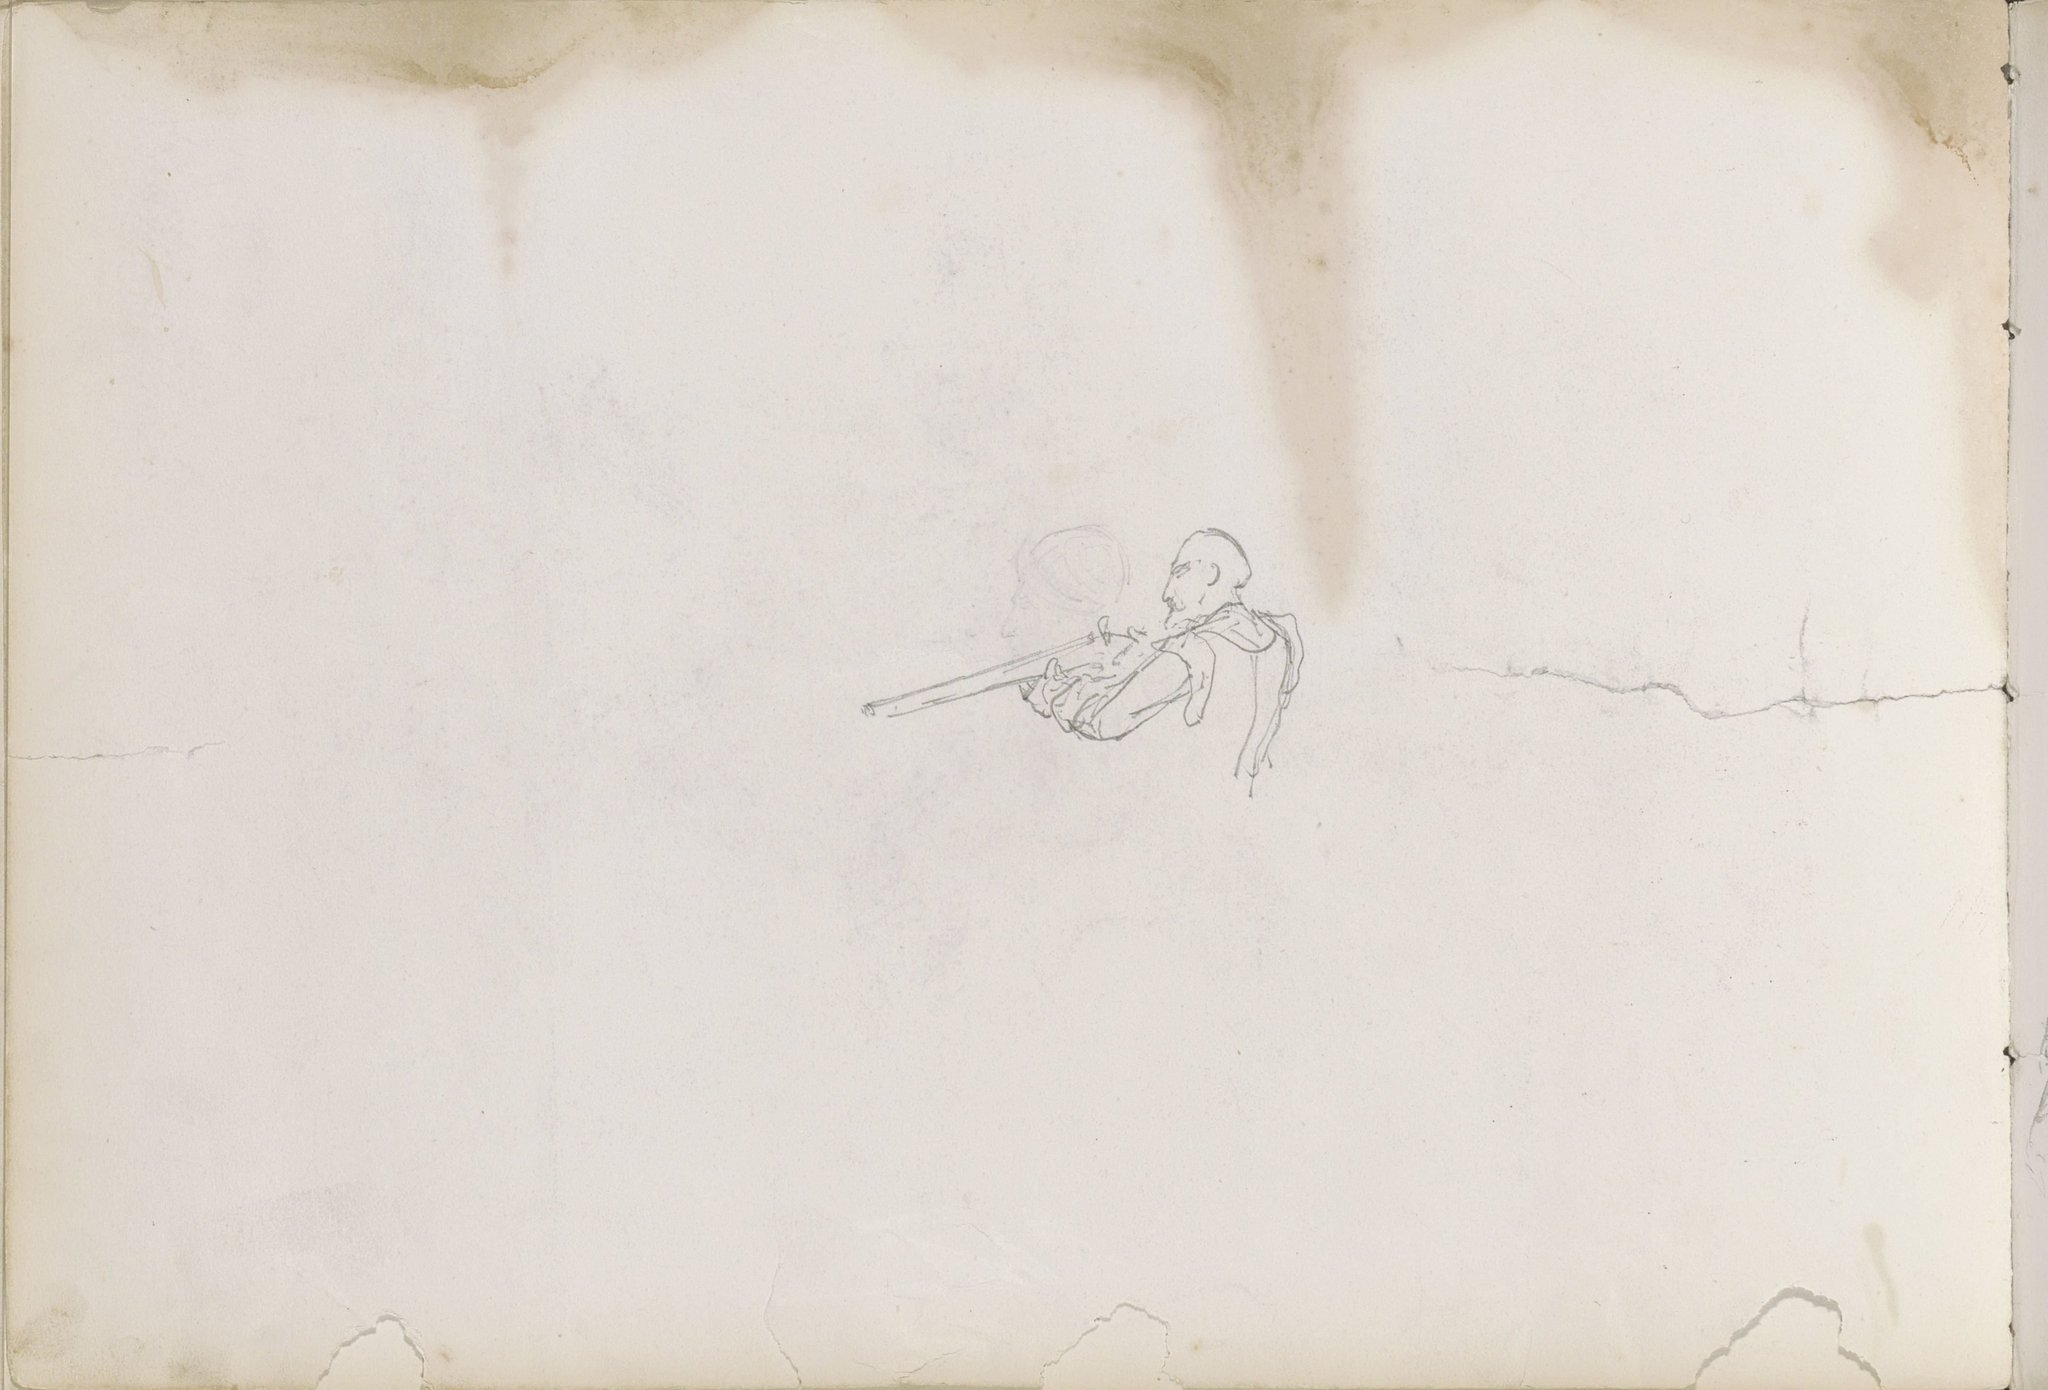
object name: sketchbook leaf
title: Soldaat met geweer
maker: george hendrik breitner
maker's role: draughtsman, painter, print maker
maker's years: 1857-1923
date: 1873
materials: paper, pencil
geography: rotterdam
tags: firearms: rifle, division of armed forces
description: Blad 8 verso uit een schetsboek met 25 bladen.